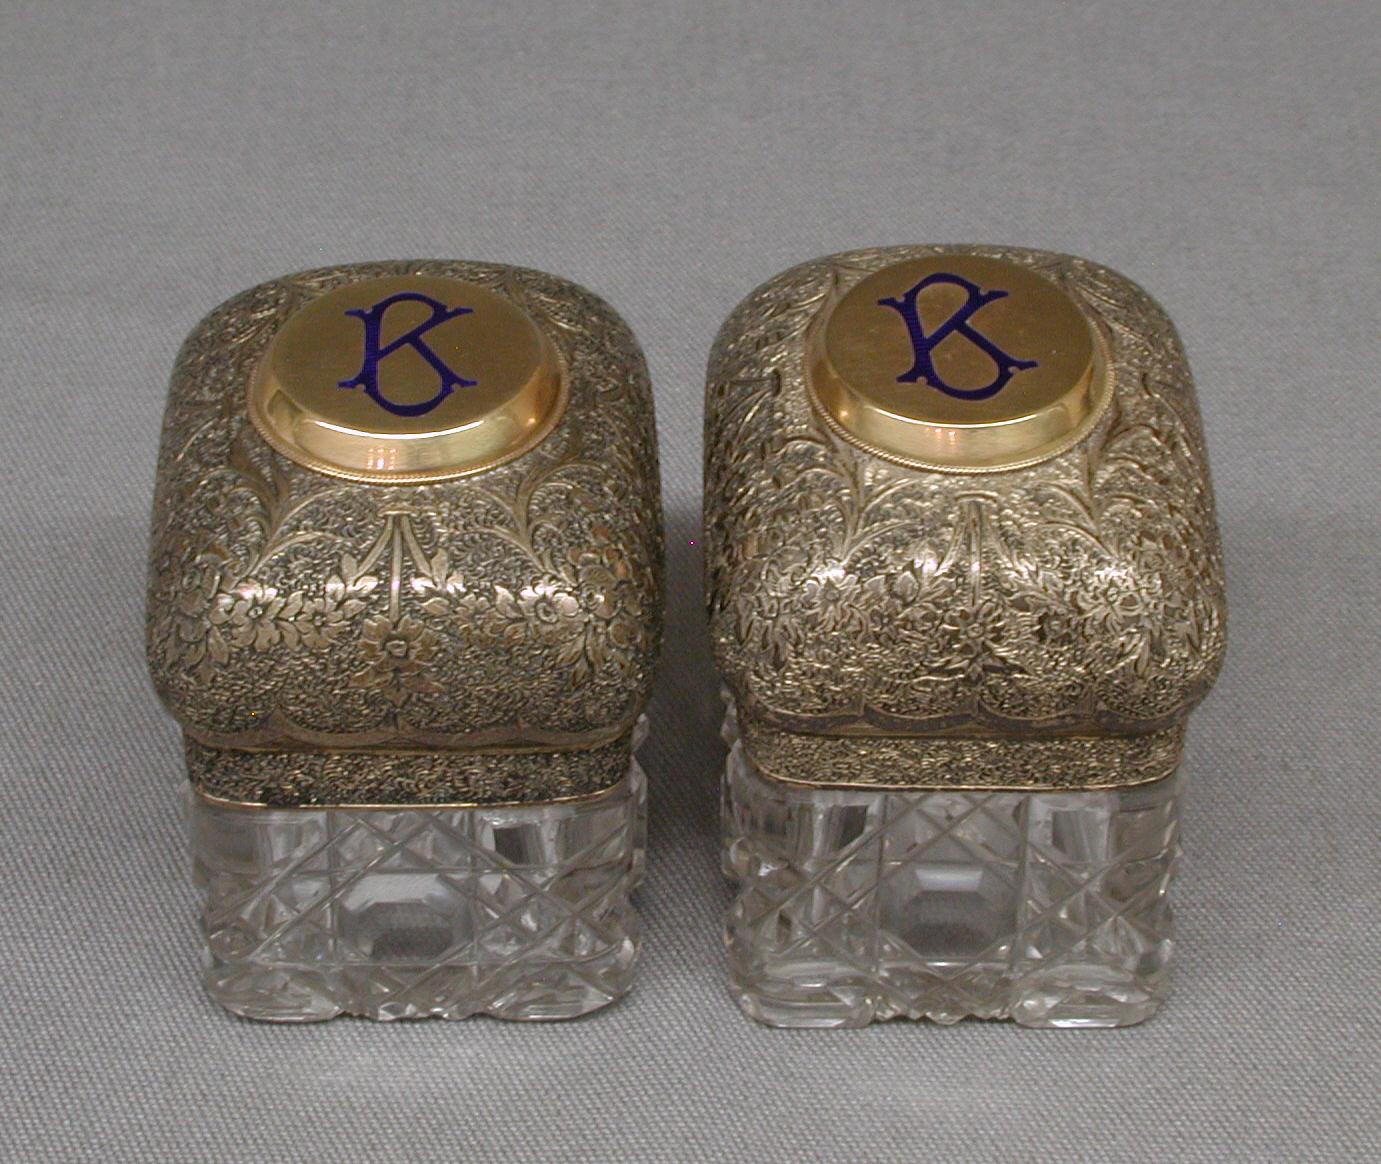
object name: cosmetic jar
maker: barnard brothers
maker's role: maker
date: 1874-1875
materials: glass, silver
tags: flowers